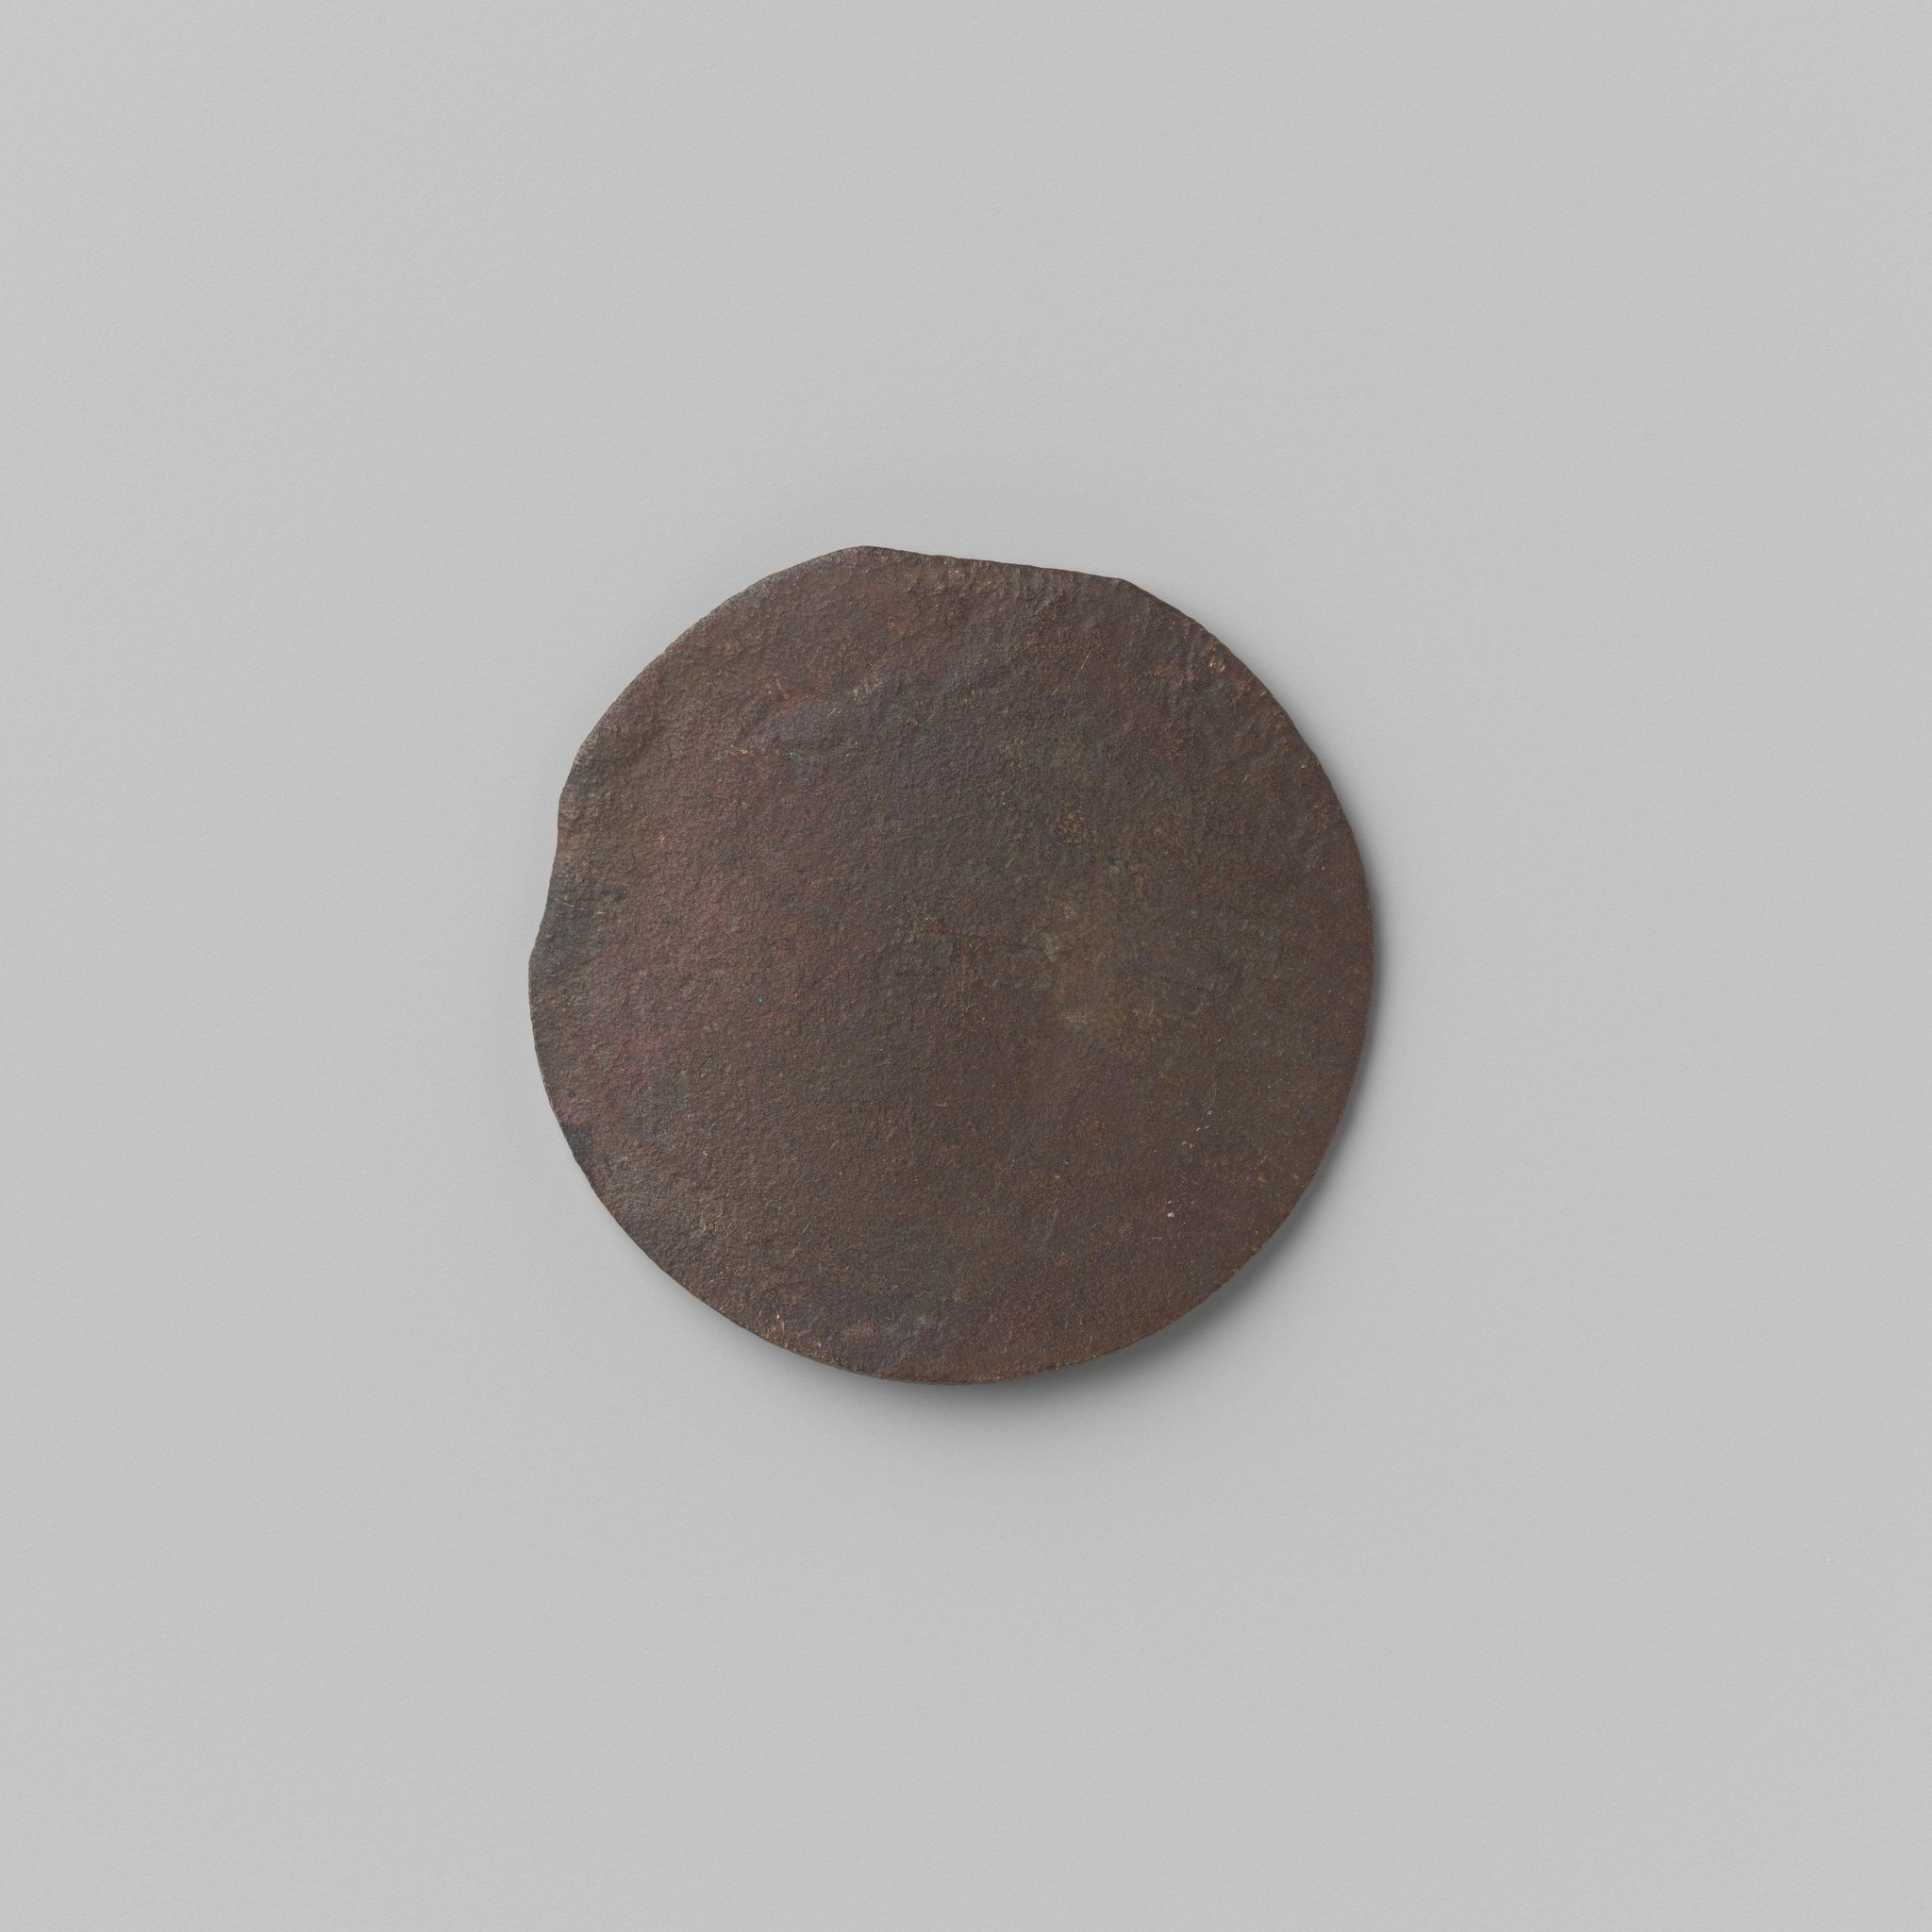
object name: rondel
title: Rondel (ongeslagen muntplaatje)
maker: Anonymous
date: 1700-1800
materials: copper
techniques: striking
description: Rondel, gevonden op het strand van Terschelling, waarschijnlijk van Zweedse oorsprong en in Göteborg of Hamburg ingeladen in een schip dat – op weg naar Lissabon – nabij Terschelling zonk.